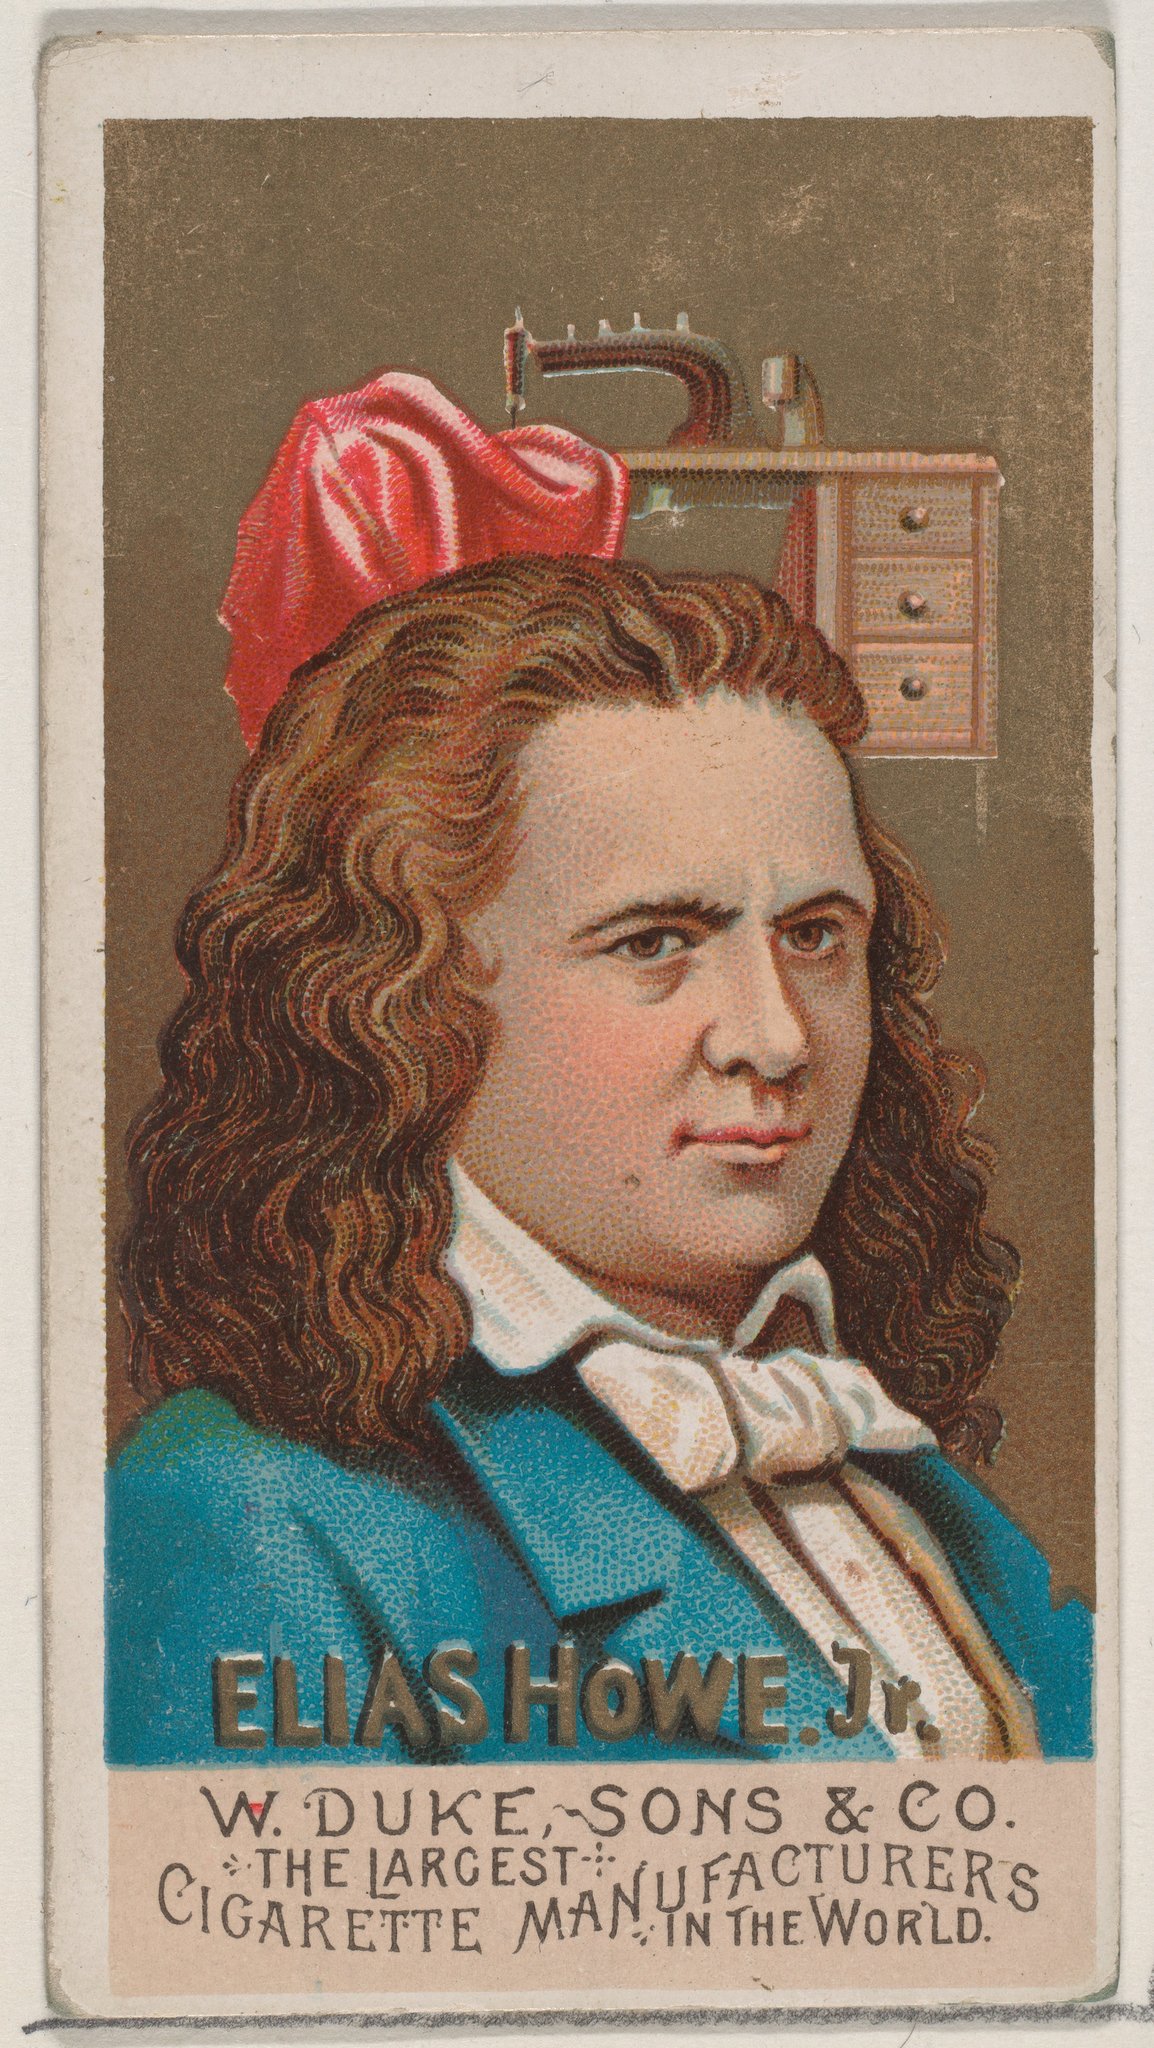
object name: print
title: Elias Howe, Jr., from the series Great Americans (N76) for Duke brand cigarettes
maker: w. duke, sons & co.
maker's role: publisher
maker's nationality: american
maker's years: 1870-1920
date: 1888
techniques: color lithograph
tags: men